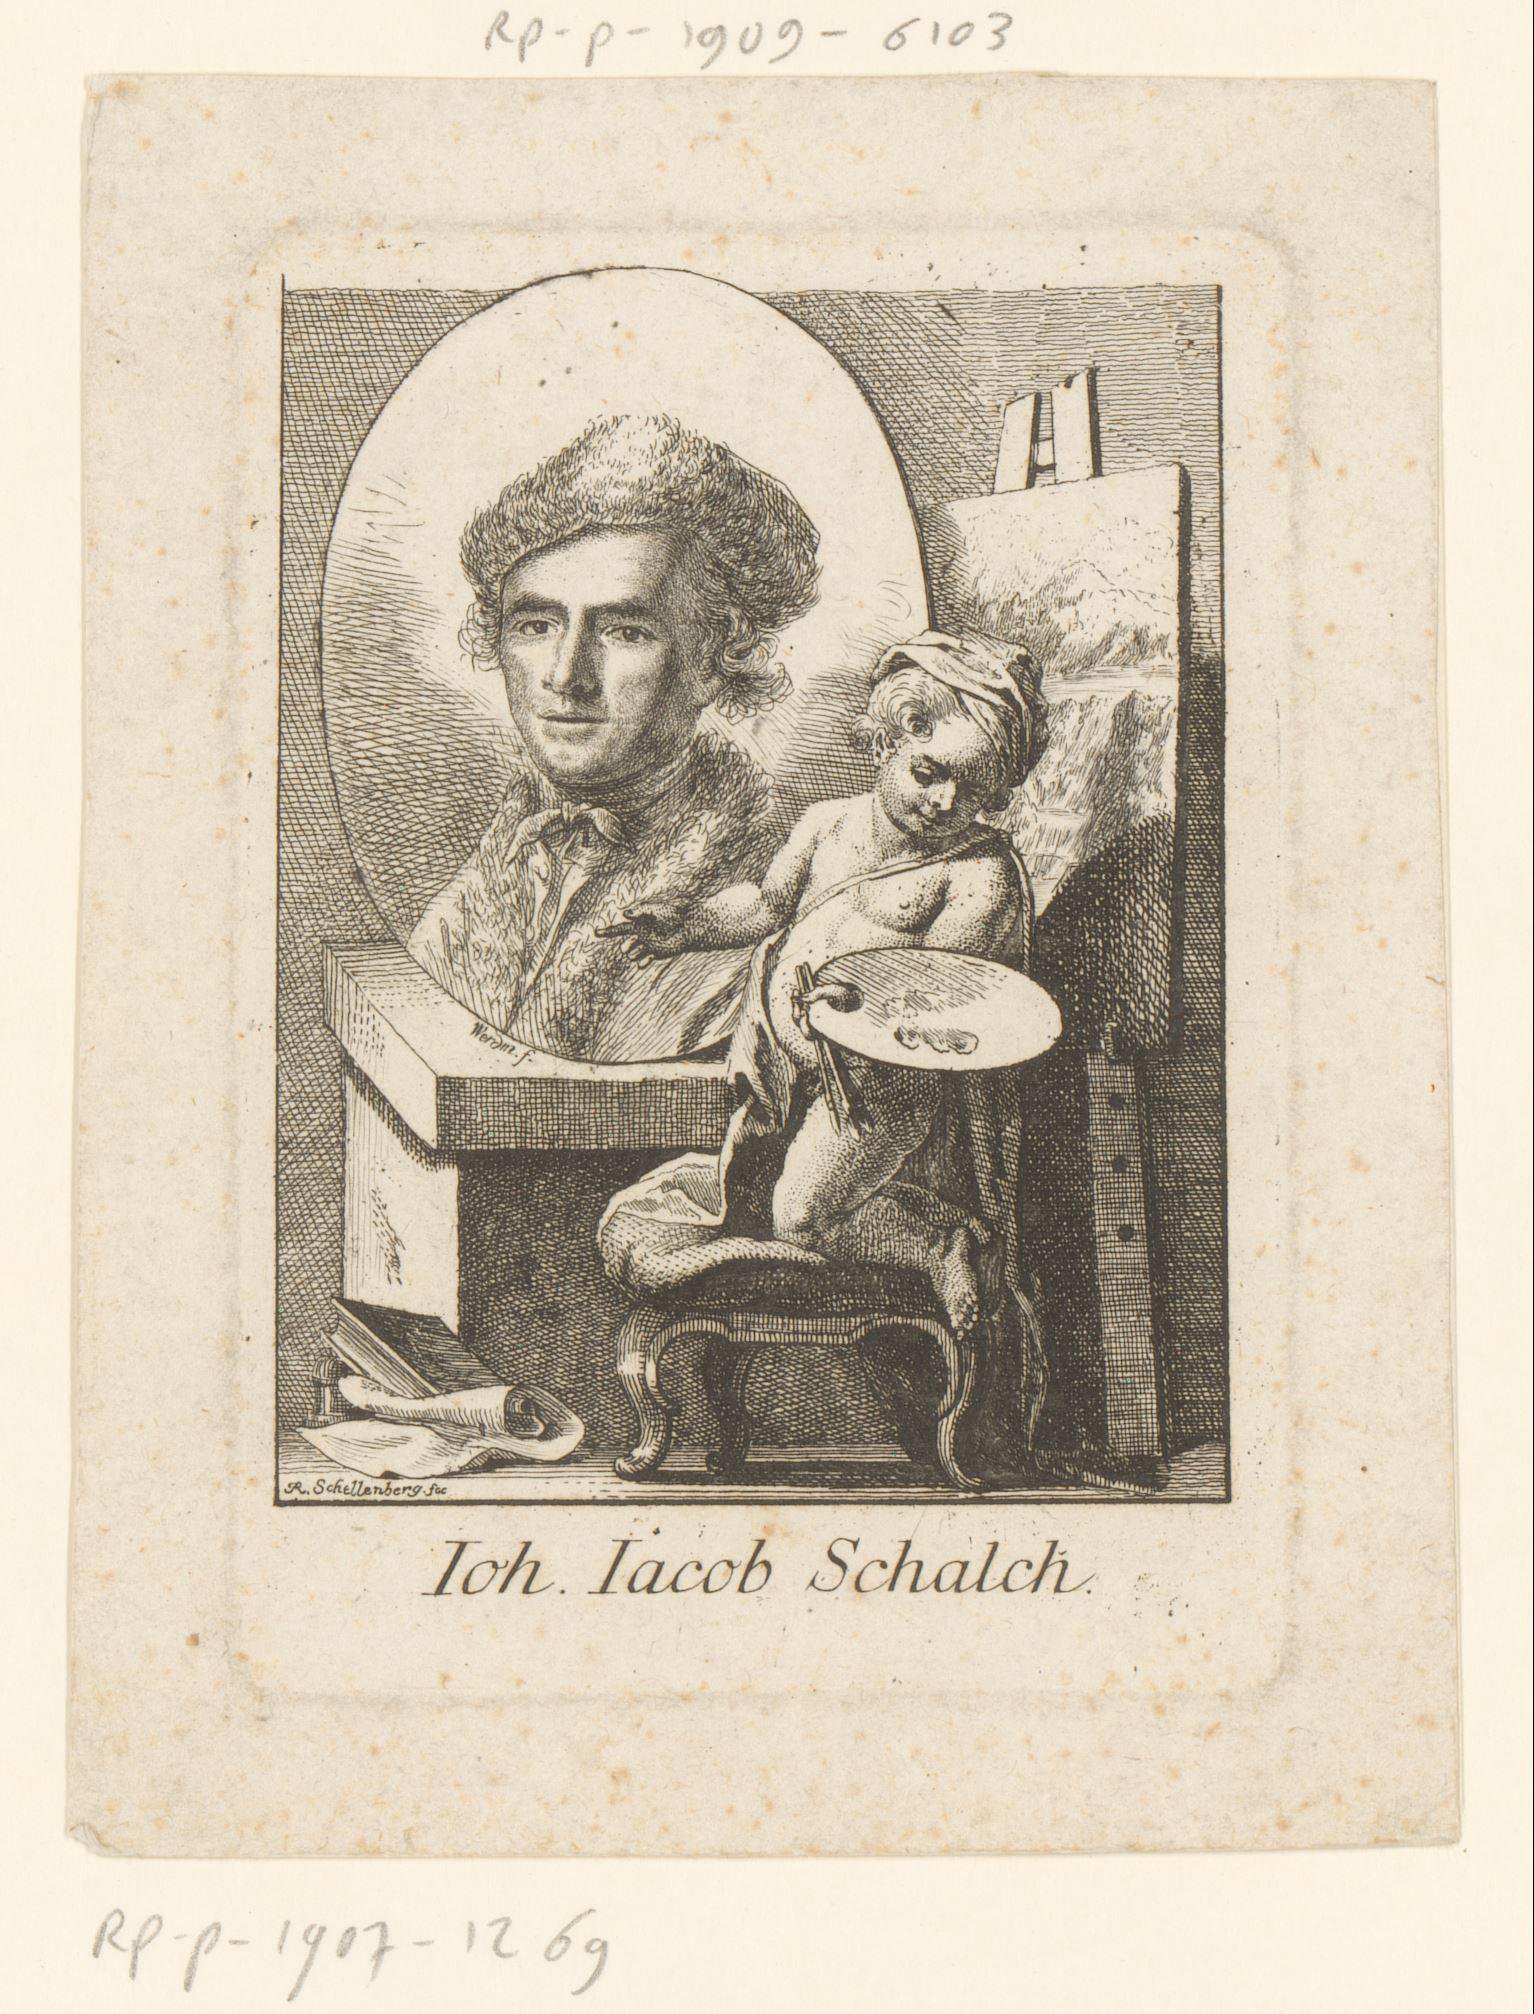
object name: print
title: Portret van Johann Jakob Schalch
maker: johann rudolph schellenberg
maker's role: print maker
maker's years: 1740-1806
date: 1750-1806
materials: paper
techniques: etching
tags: print maker, johann jakob schalch, portrait, self-portrait of painter, tools, implements of painter, cupids: 'amores', 'amoretti', 'putti'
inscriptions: collector's mark: Lugt 2228